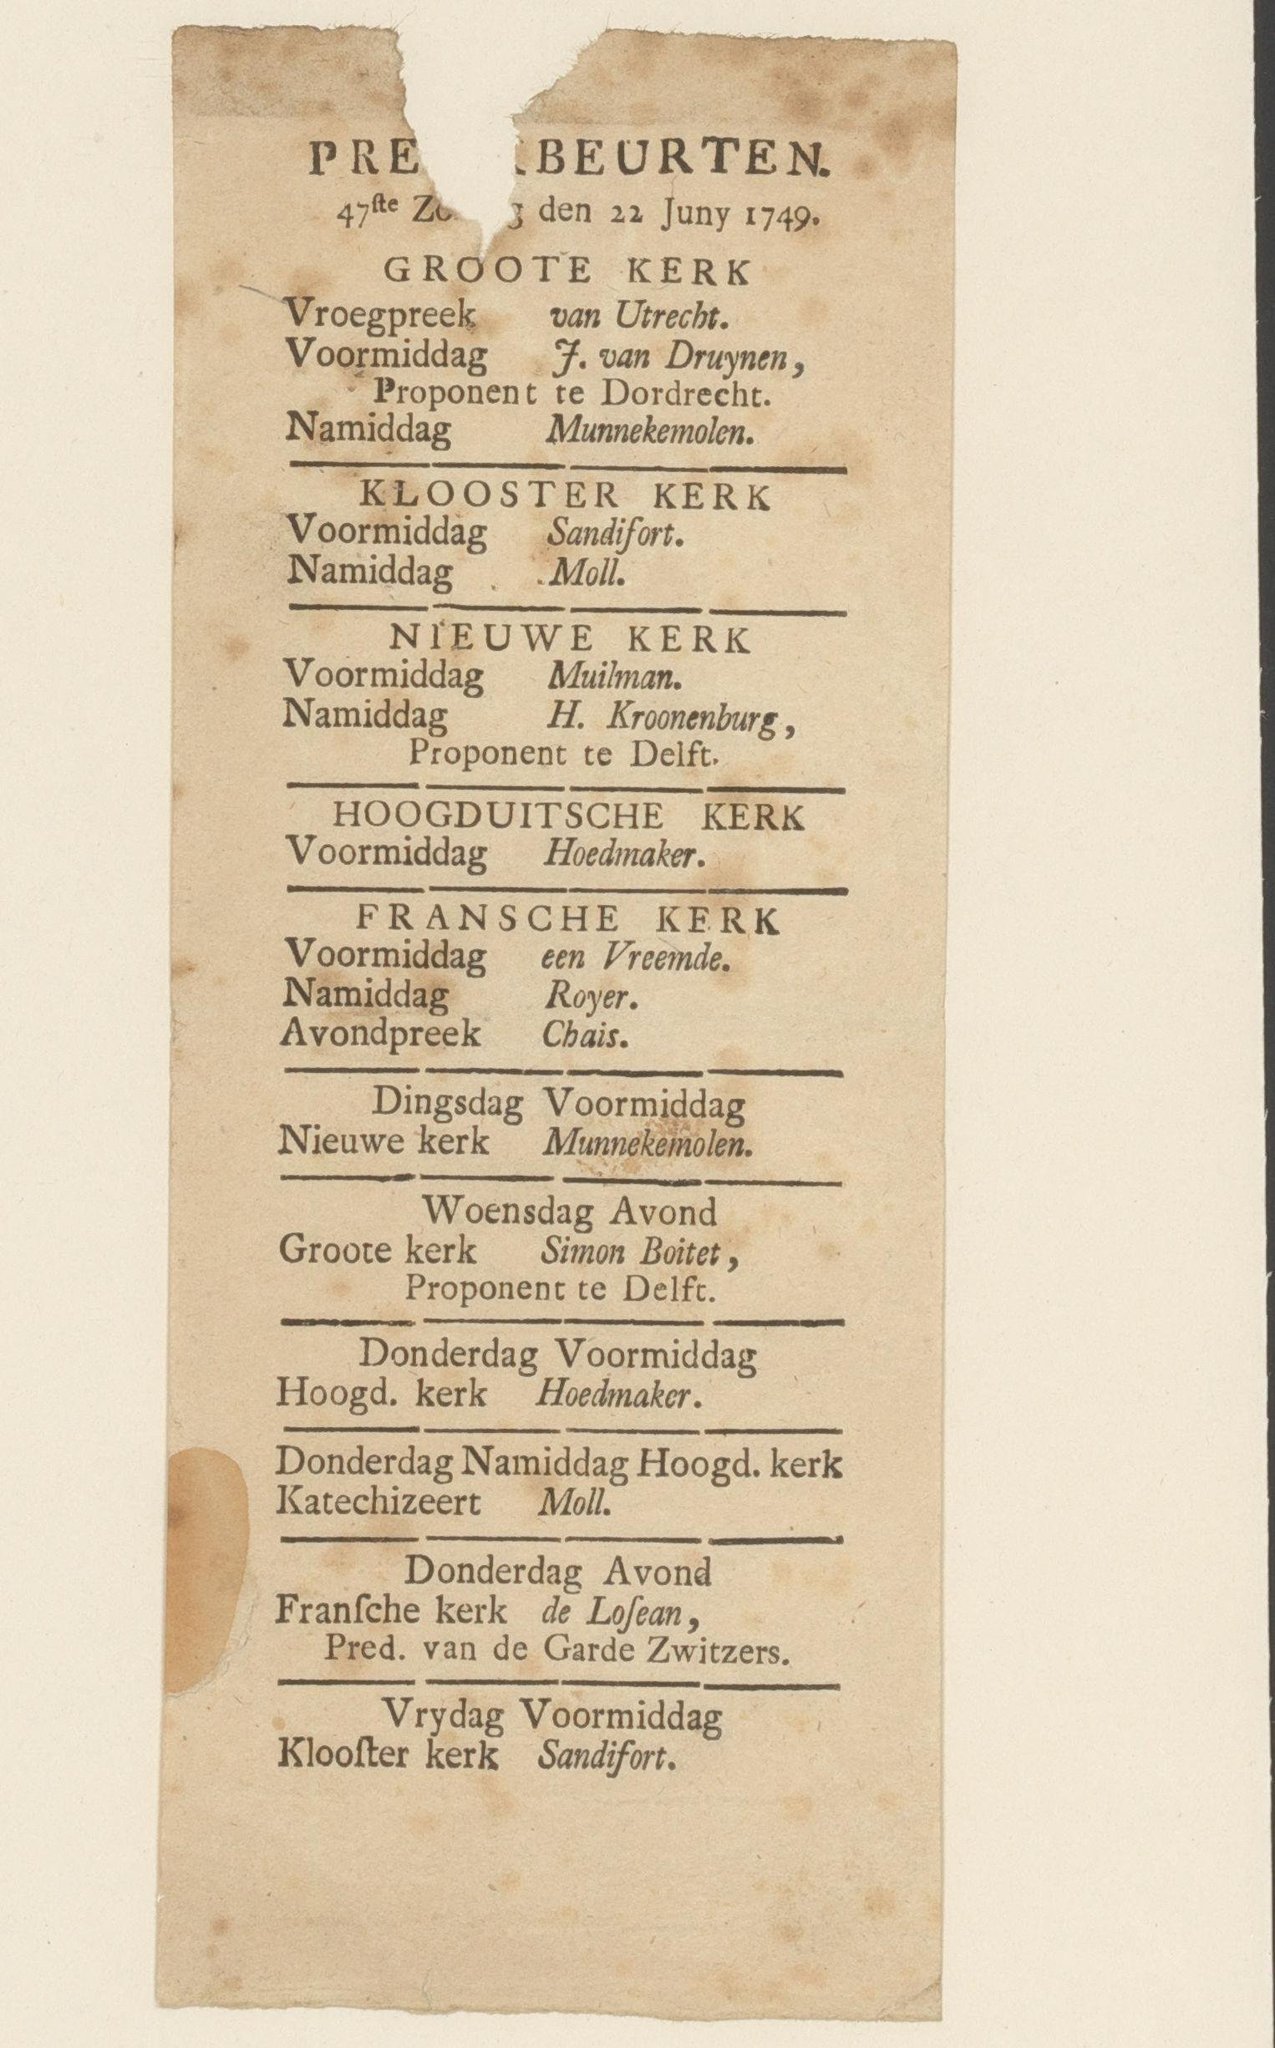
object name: text sheet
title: Preken in Groningen in de week van 22 juni 1749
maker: Anonymous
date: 1749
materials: paper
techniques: letterpress printing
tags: preaching (in general)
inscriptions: collector's mark: Lugt 1641, stamp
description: Preken in Groningen in de week van 22 juni 1749, met de namen van de predikanten. Onderwerpsrubrieken binnen de Atlas Zeden en Gewoonten: Godsdienst, Predikbeurtenlijstjes.